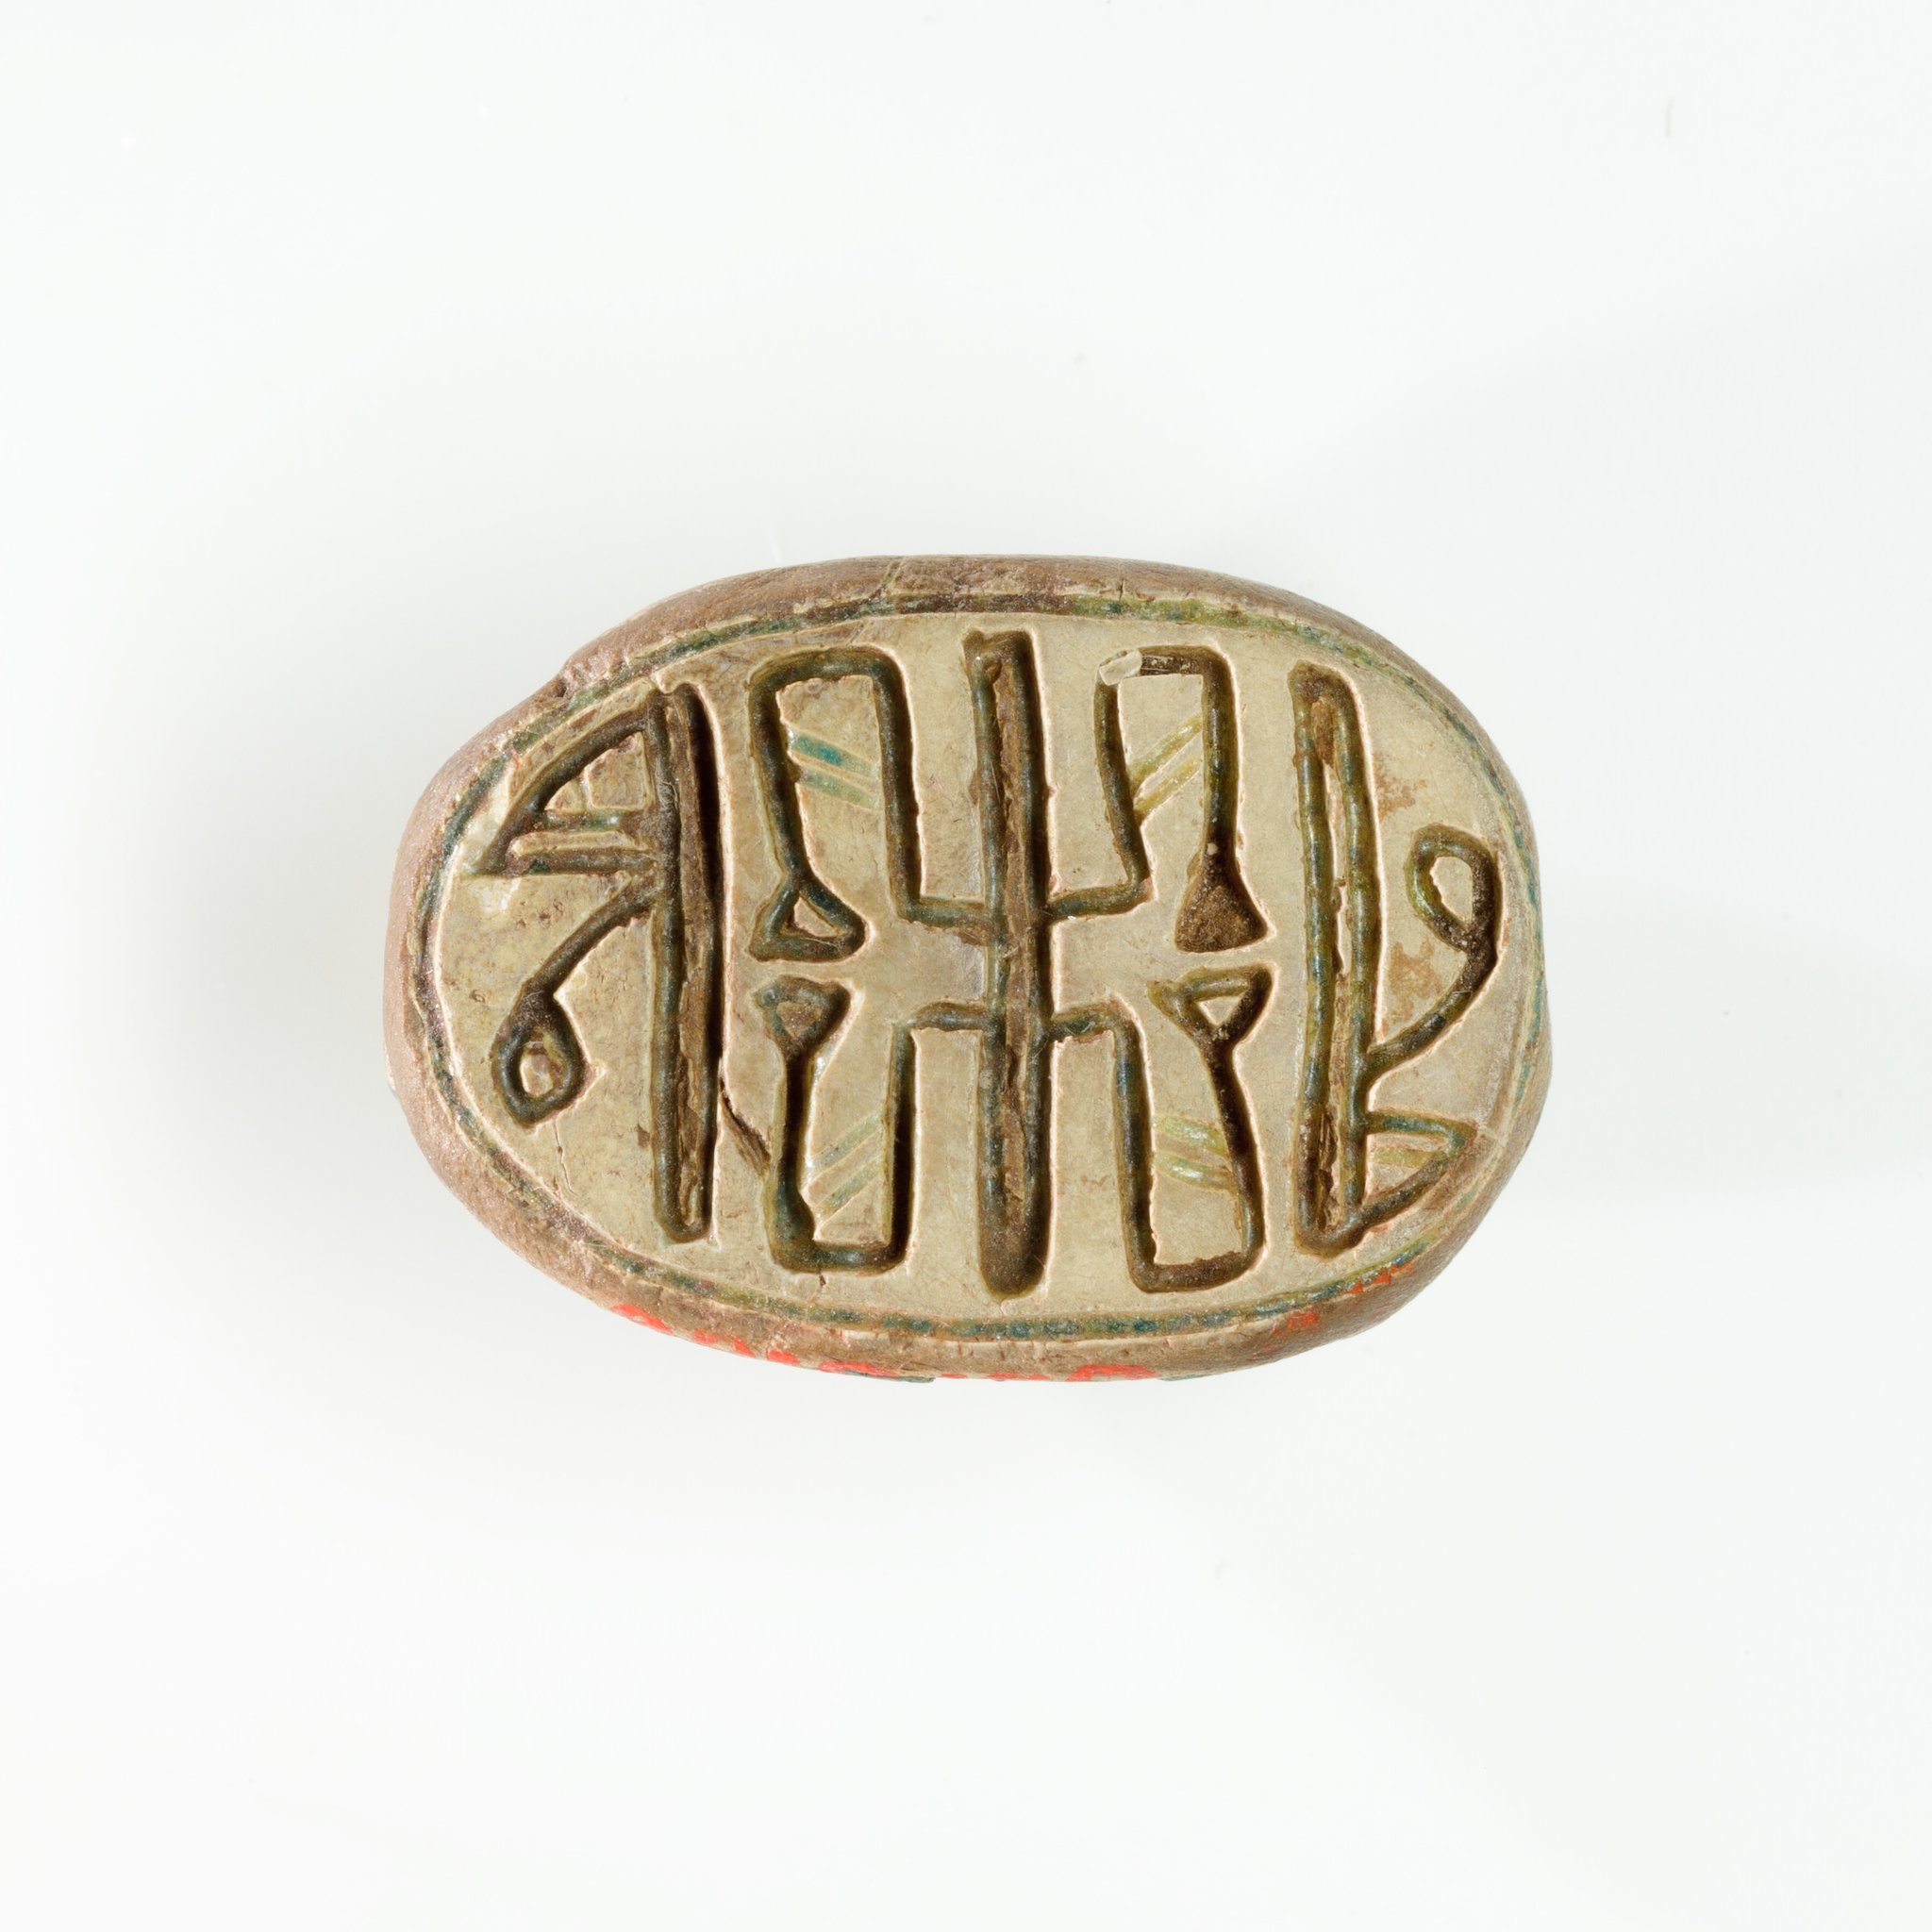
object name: scarab, union of two land, rennefer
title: Scarab from Rennefer's Burial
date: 1504-1447 BCE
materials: faience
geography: egypt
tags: hieroglyphs,scarabs